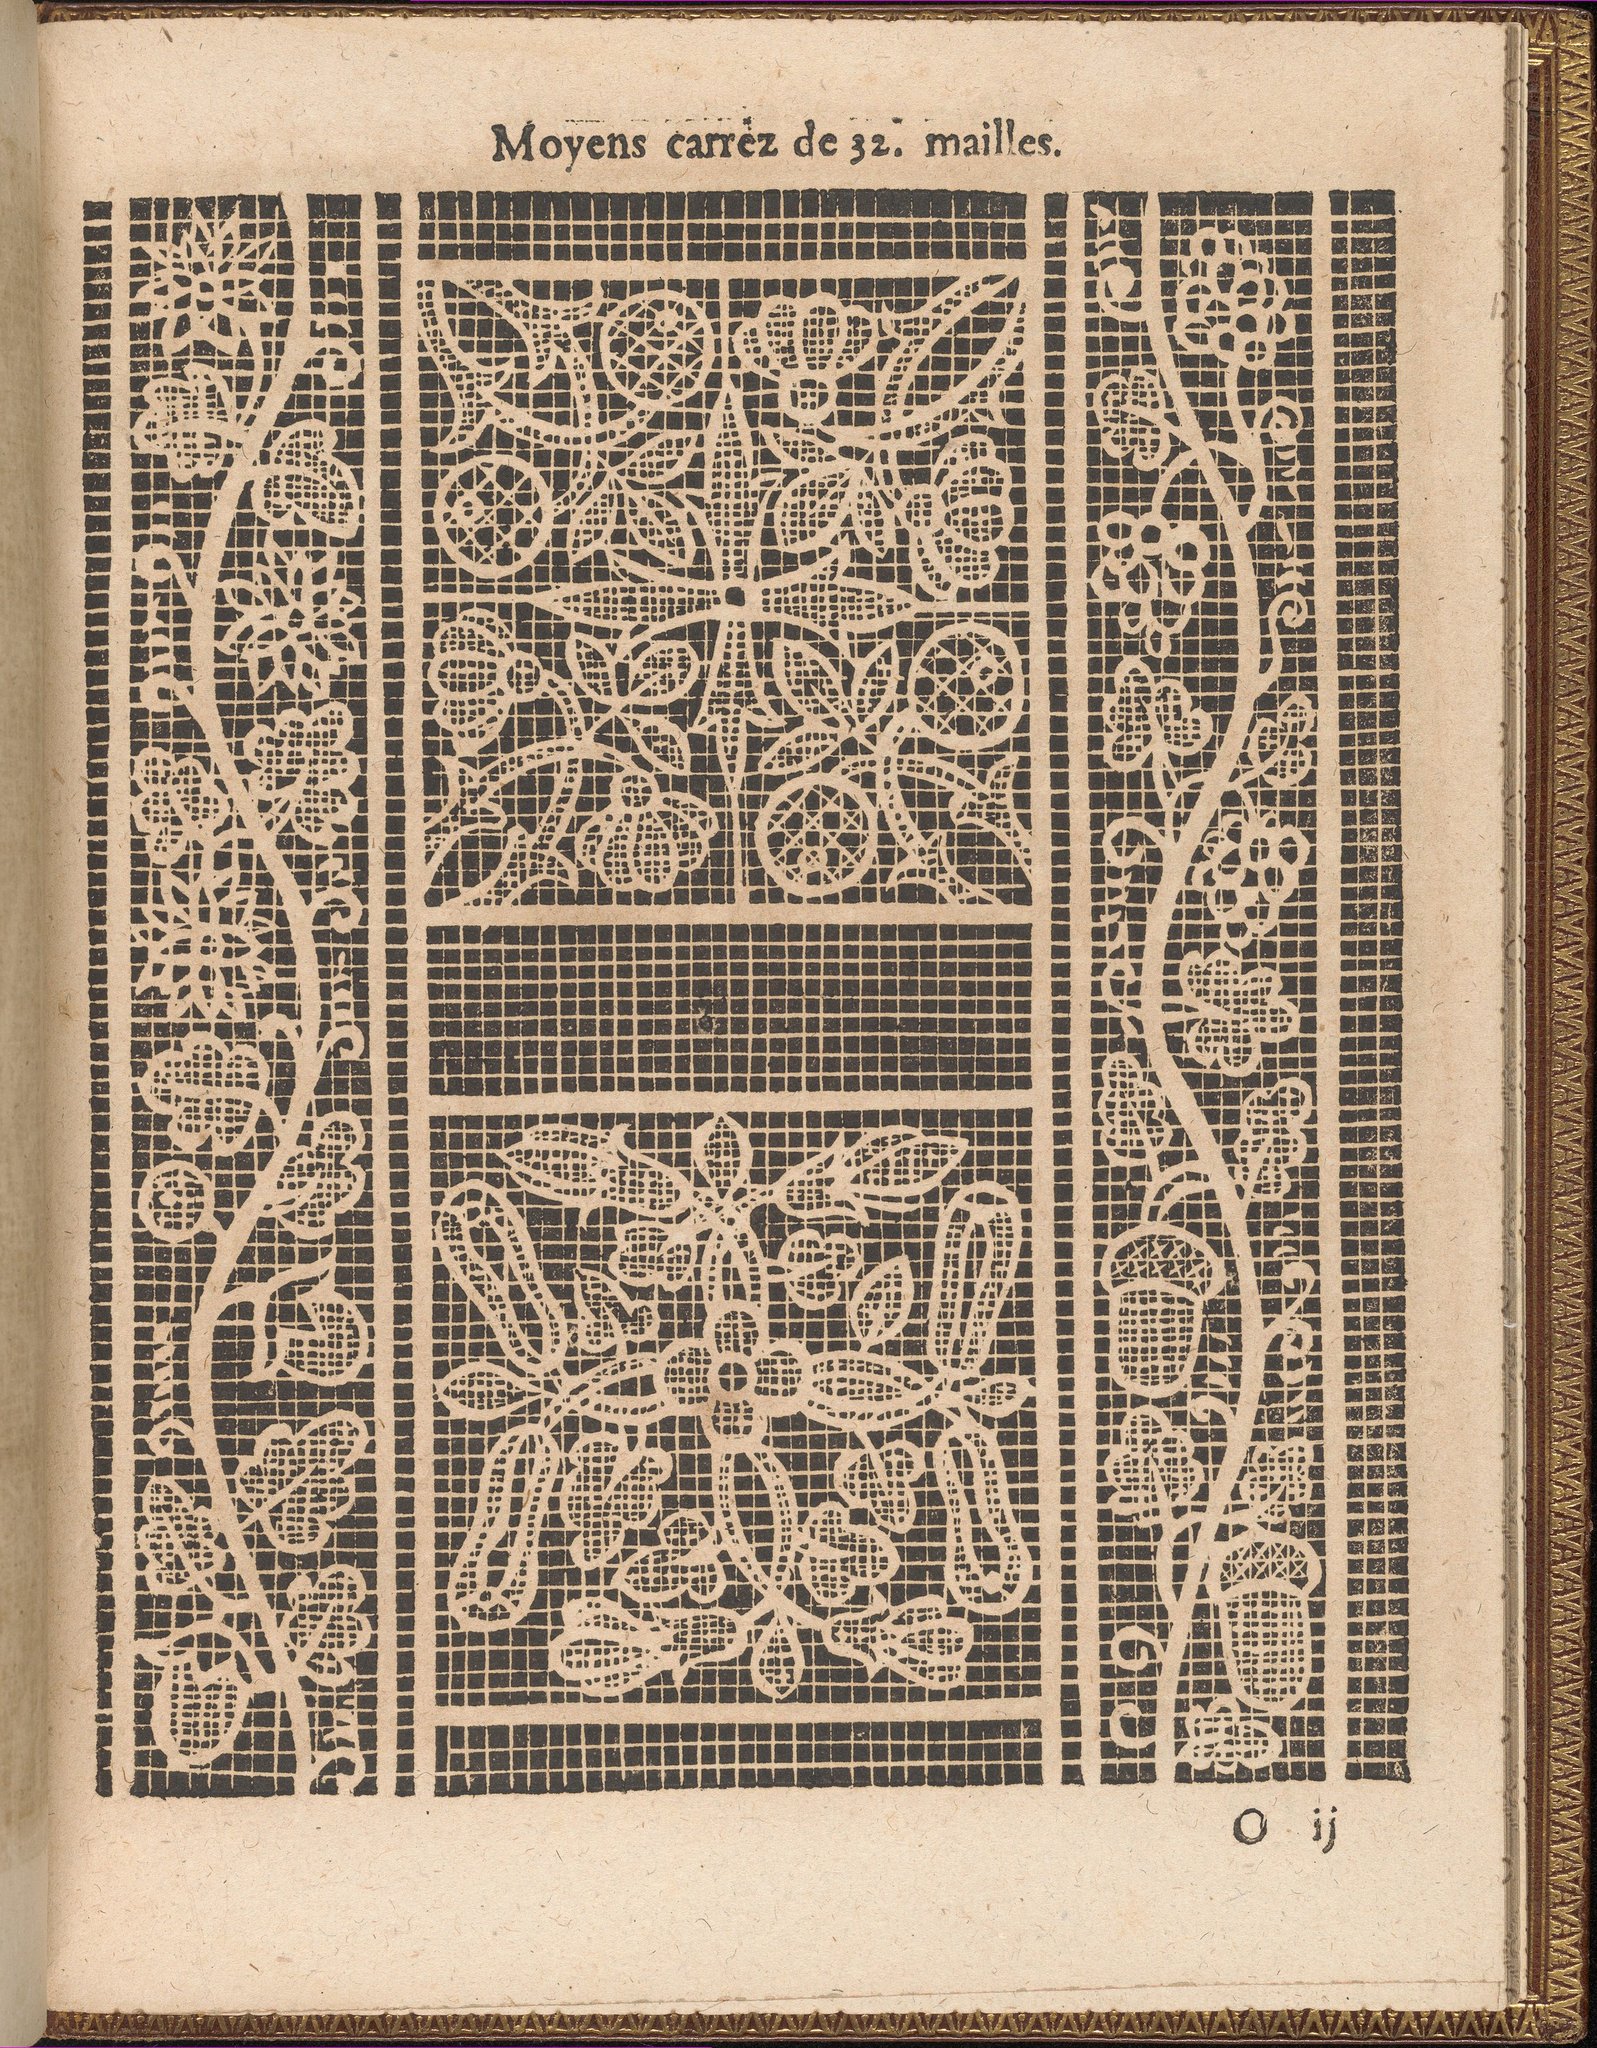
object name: book print ornament architecture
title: La Pratique de l'Aiguille, page 53 (recto)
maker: matthias mignerak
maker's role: author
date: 1605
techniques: woodcut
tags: ornament,grapes,acorns